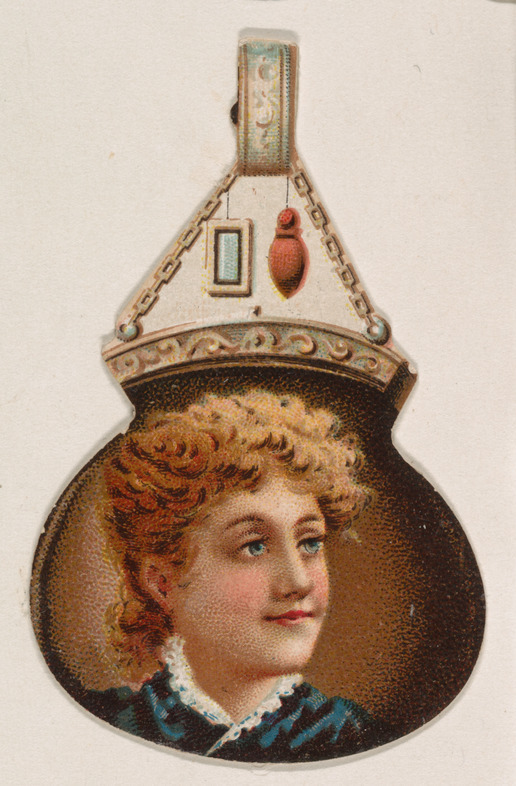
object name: print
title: Woman's portrait on novelty, from the Novelties series (N228, Type 3) issued by Kinney Bros.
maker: kinney brothers tobacco company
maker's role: publisher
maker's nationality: american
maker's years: 1869-2011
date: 1889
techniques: color lithograph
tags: portraits,women